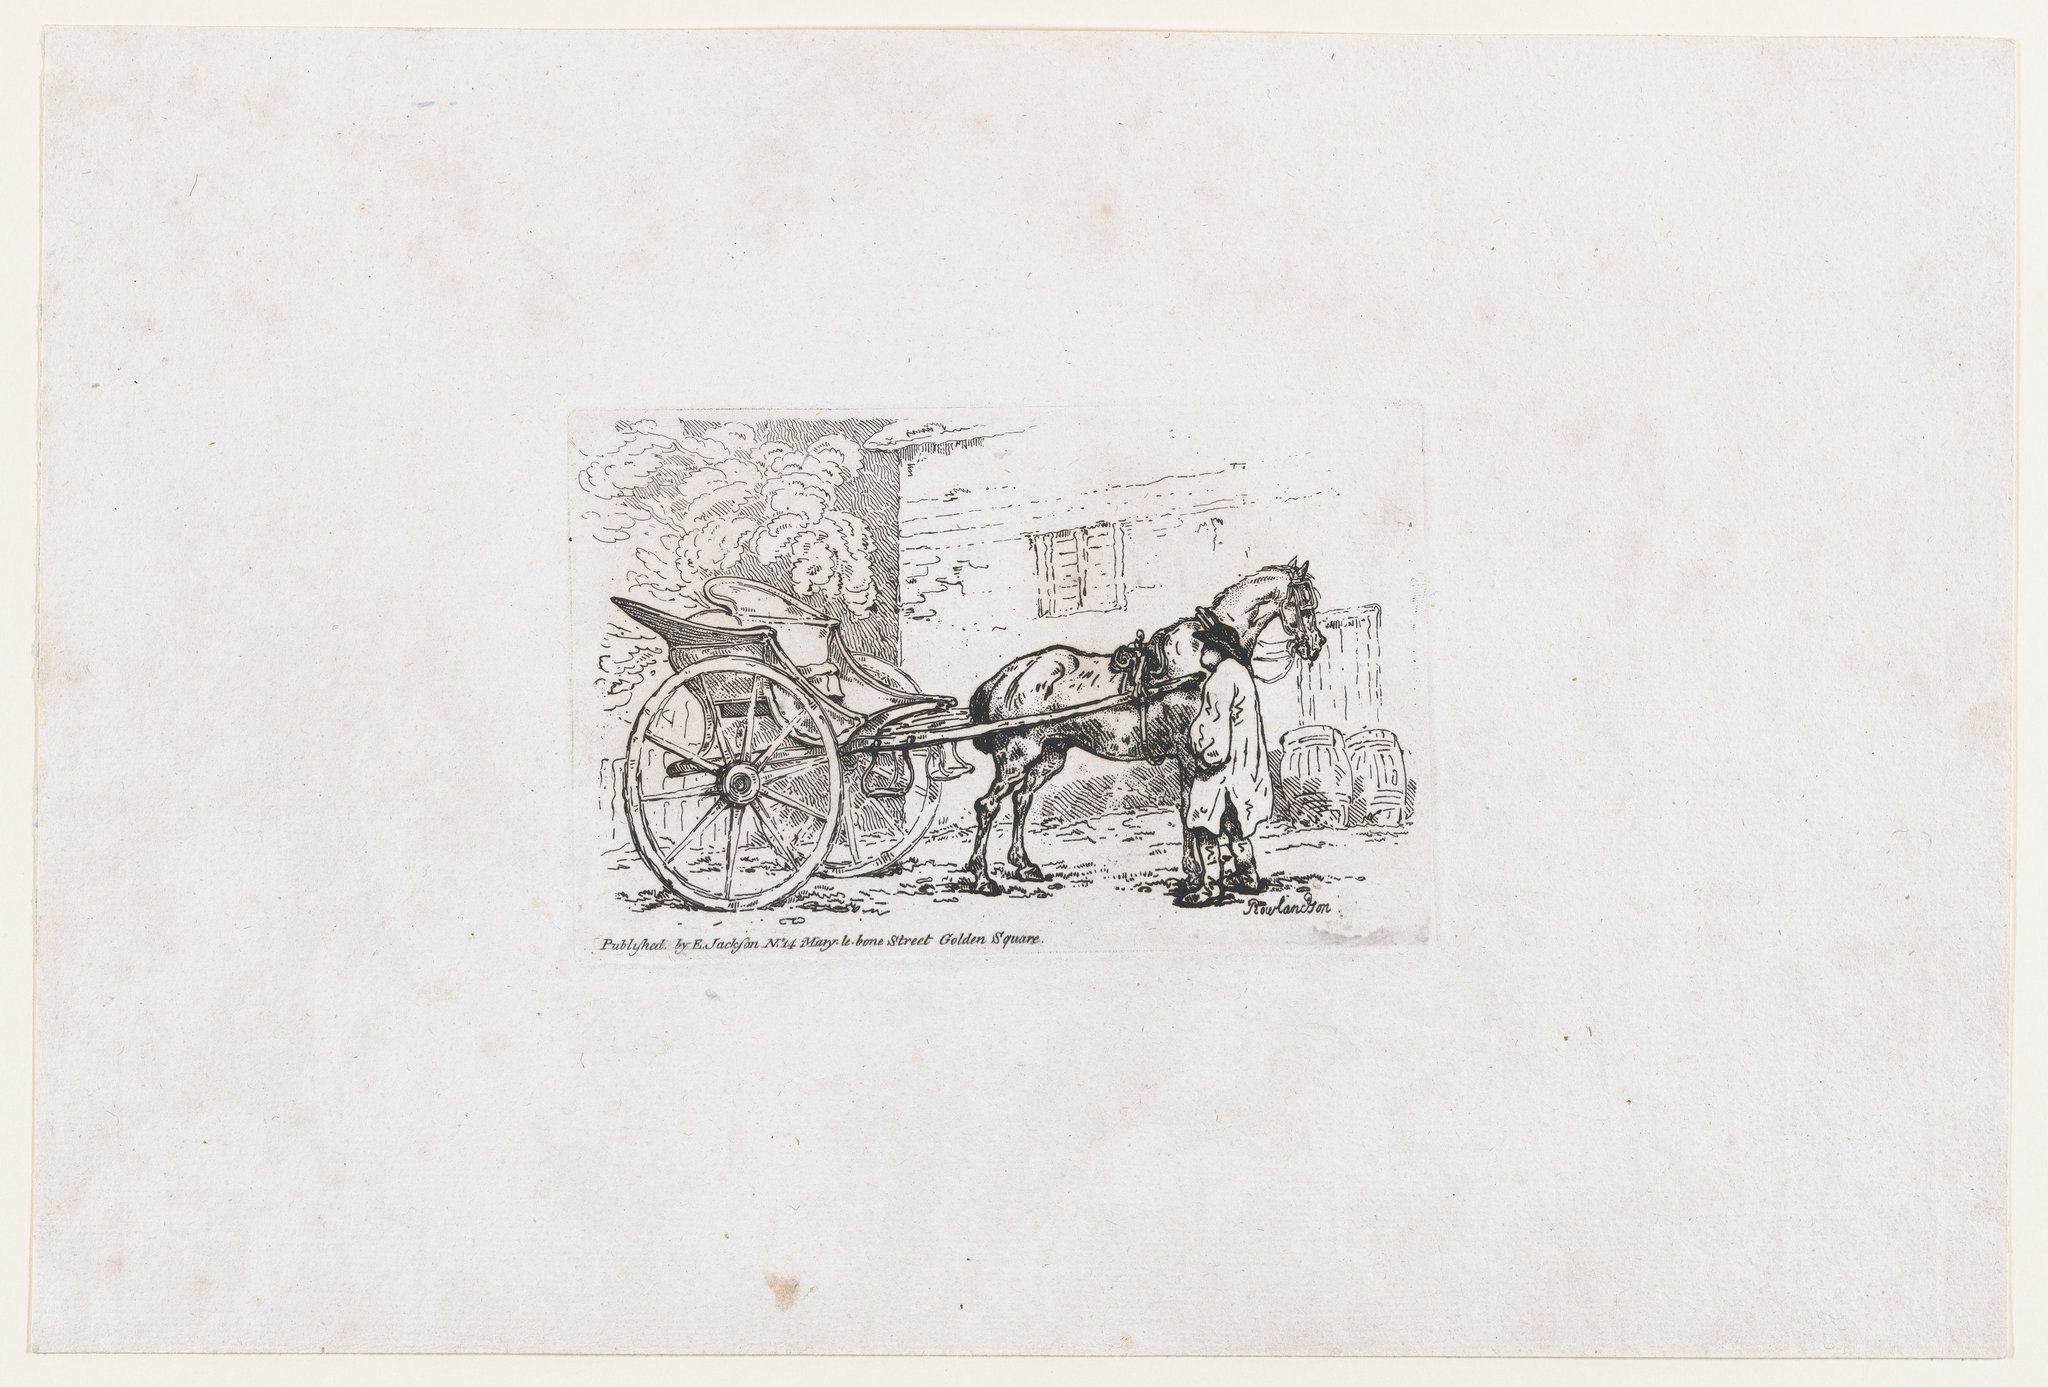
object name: print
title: A Cabriolet with a Groom Parked Beside an Outhouse [A Gig], from The Rhedarium, or, A New Book of Horses and Carriages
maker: thomas rowlandson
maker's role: artist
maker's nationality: british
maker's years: 1757-1827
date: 1784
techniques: etching, stippling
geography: london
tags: horses,carriages